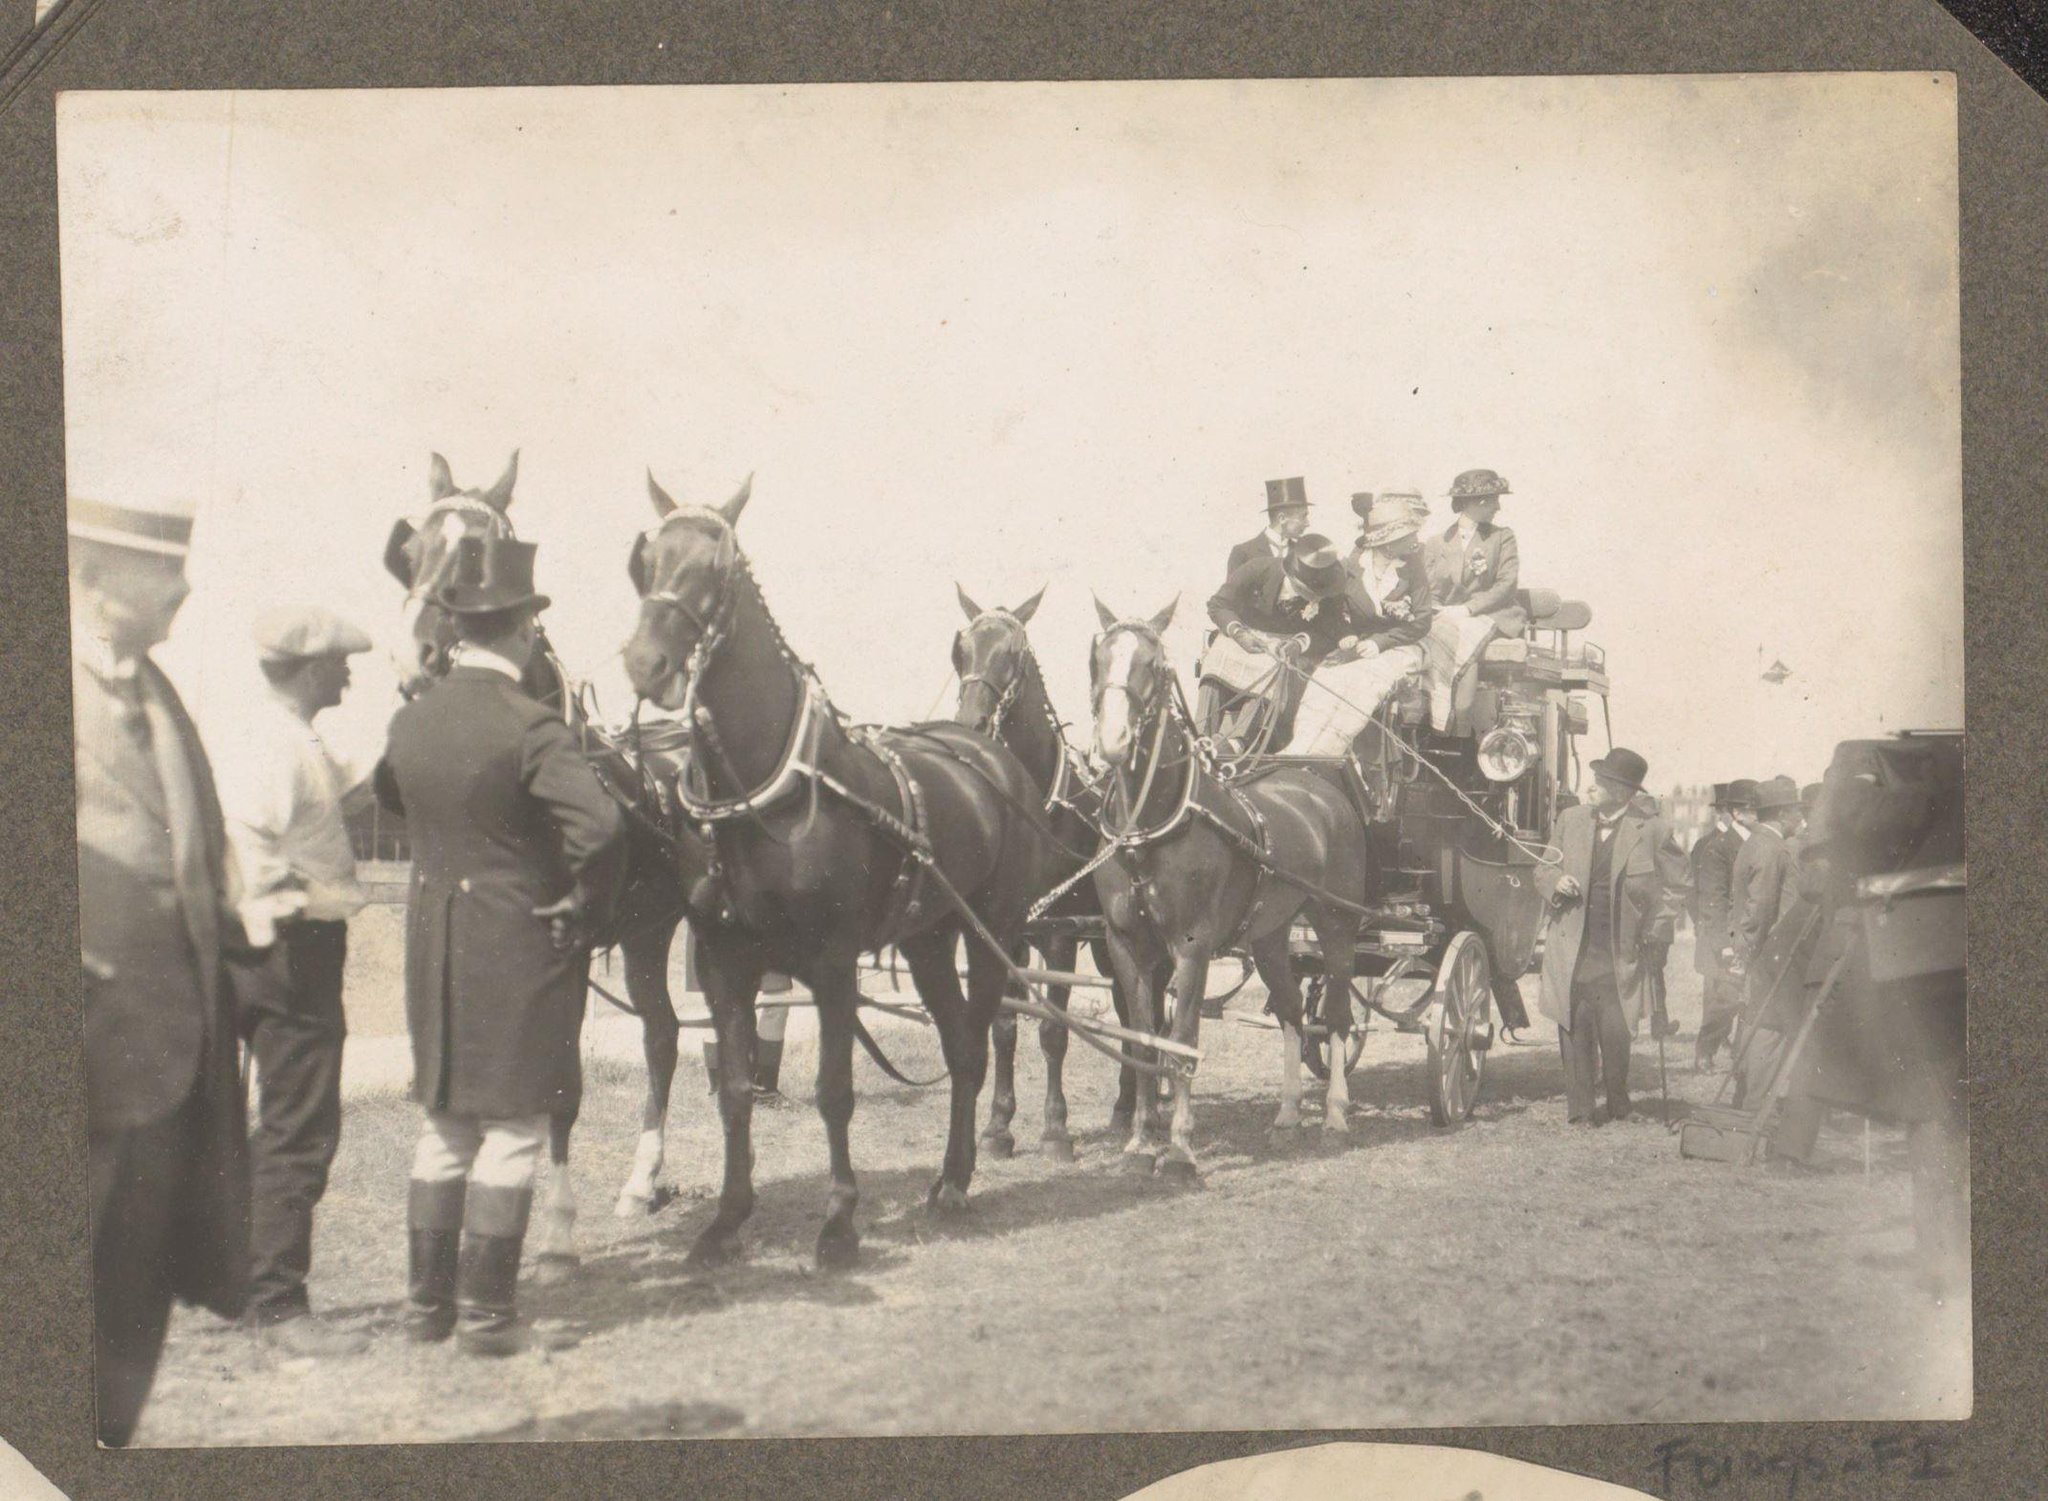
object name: album leaf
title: Vierspan van de Amsterdamsche Rijtuig-Maatschappij tijdens de eerste marathon van Nederland op Houtrust, Den Haag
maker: Anonymous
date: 1914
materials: photographic support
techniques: gelatin silver print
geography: the hague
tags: riding a horse, ass, or mule; rider, horseman, hunting, chase, hunting-ground, horse-racing, four-wheeled vehicle drawn by more than three animals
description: Onderdeel van Fotoalbum van de heer Brams, opperhoutvester van koningin Wilhelmina op Koninklijke Houtvesterij Het Loo.